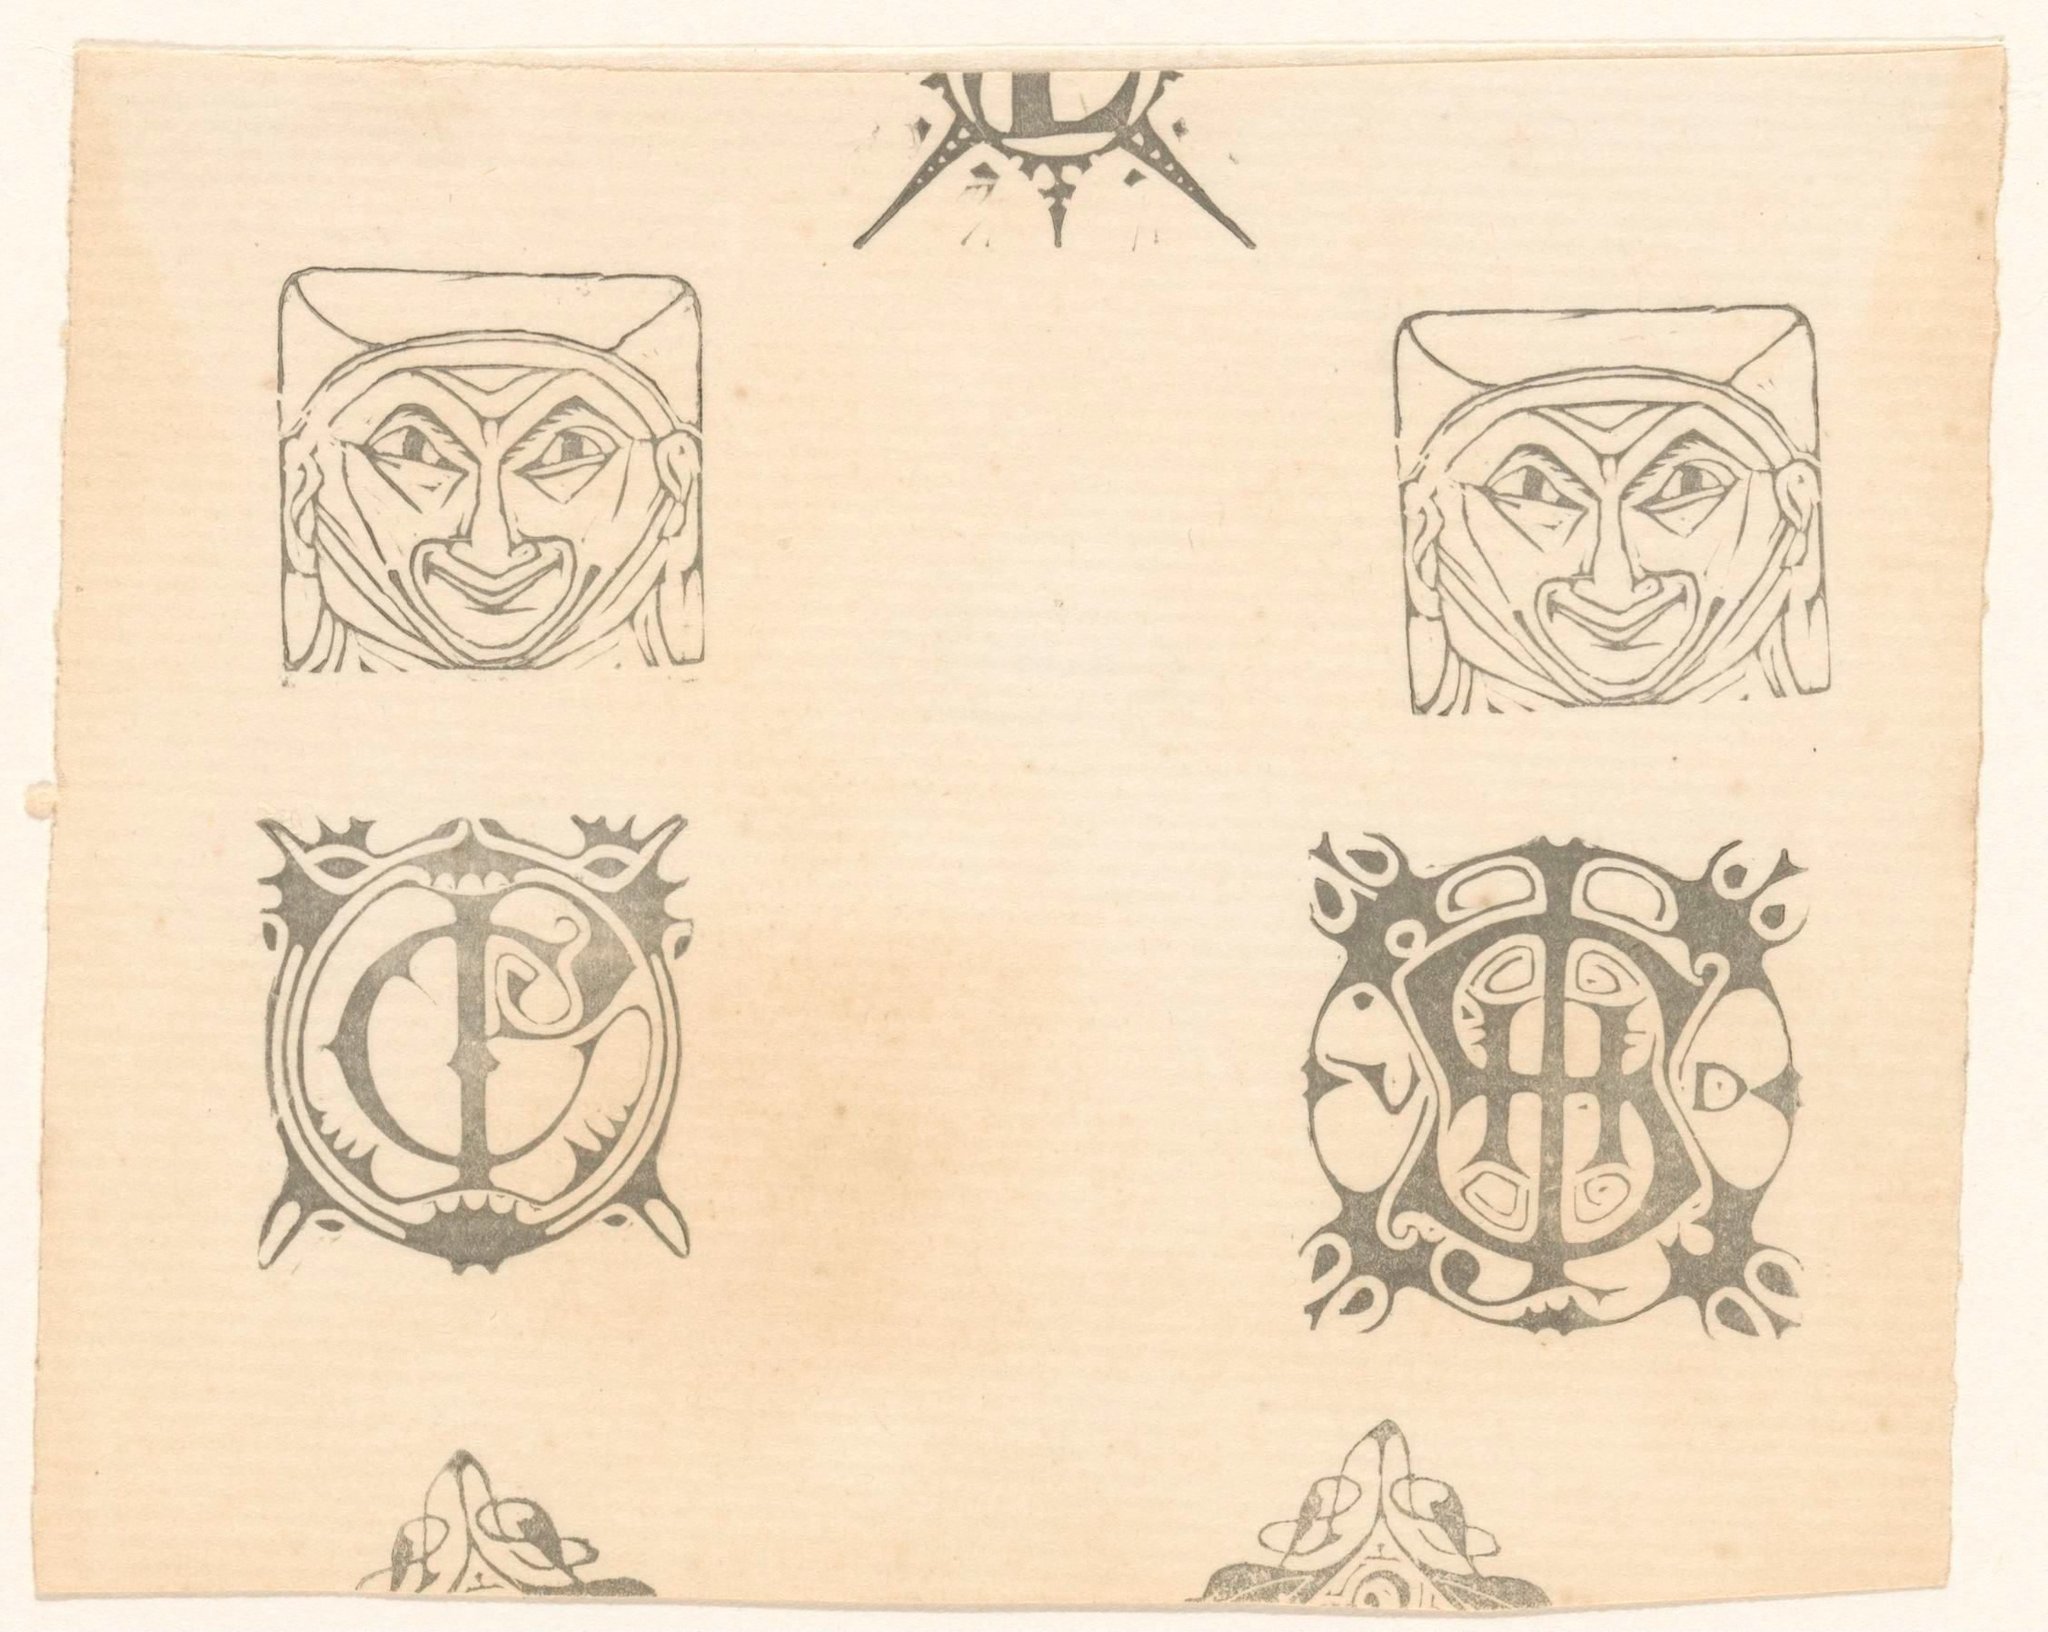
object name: print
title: Blad met twee vignetten en twee monogrammen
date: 1895-1896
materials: paper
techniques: woodcut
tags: initial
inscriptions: collector's mark: Lugt 2228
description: Vignet mogelijk gebruikt voor: Licht en waarheid. Orgaan van de vereeniging 'Wie Denkt Overwint'. Amsterdam: Wie Denkt Overwint, 12 oktober 1895.